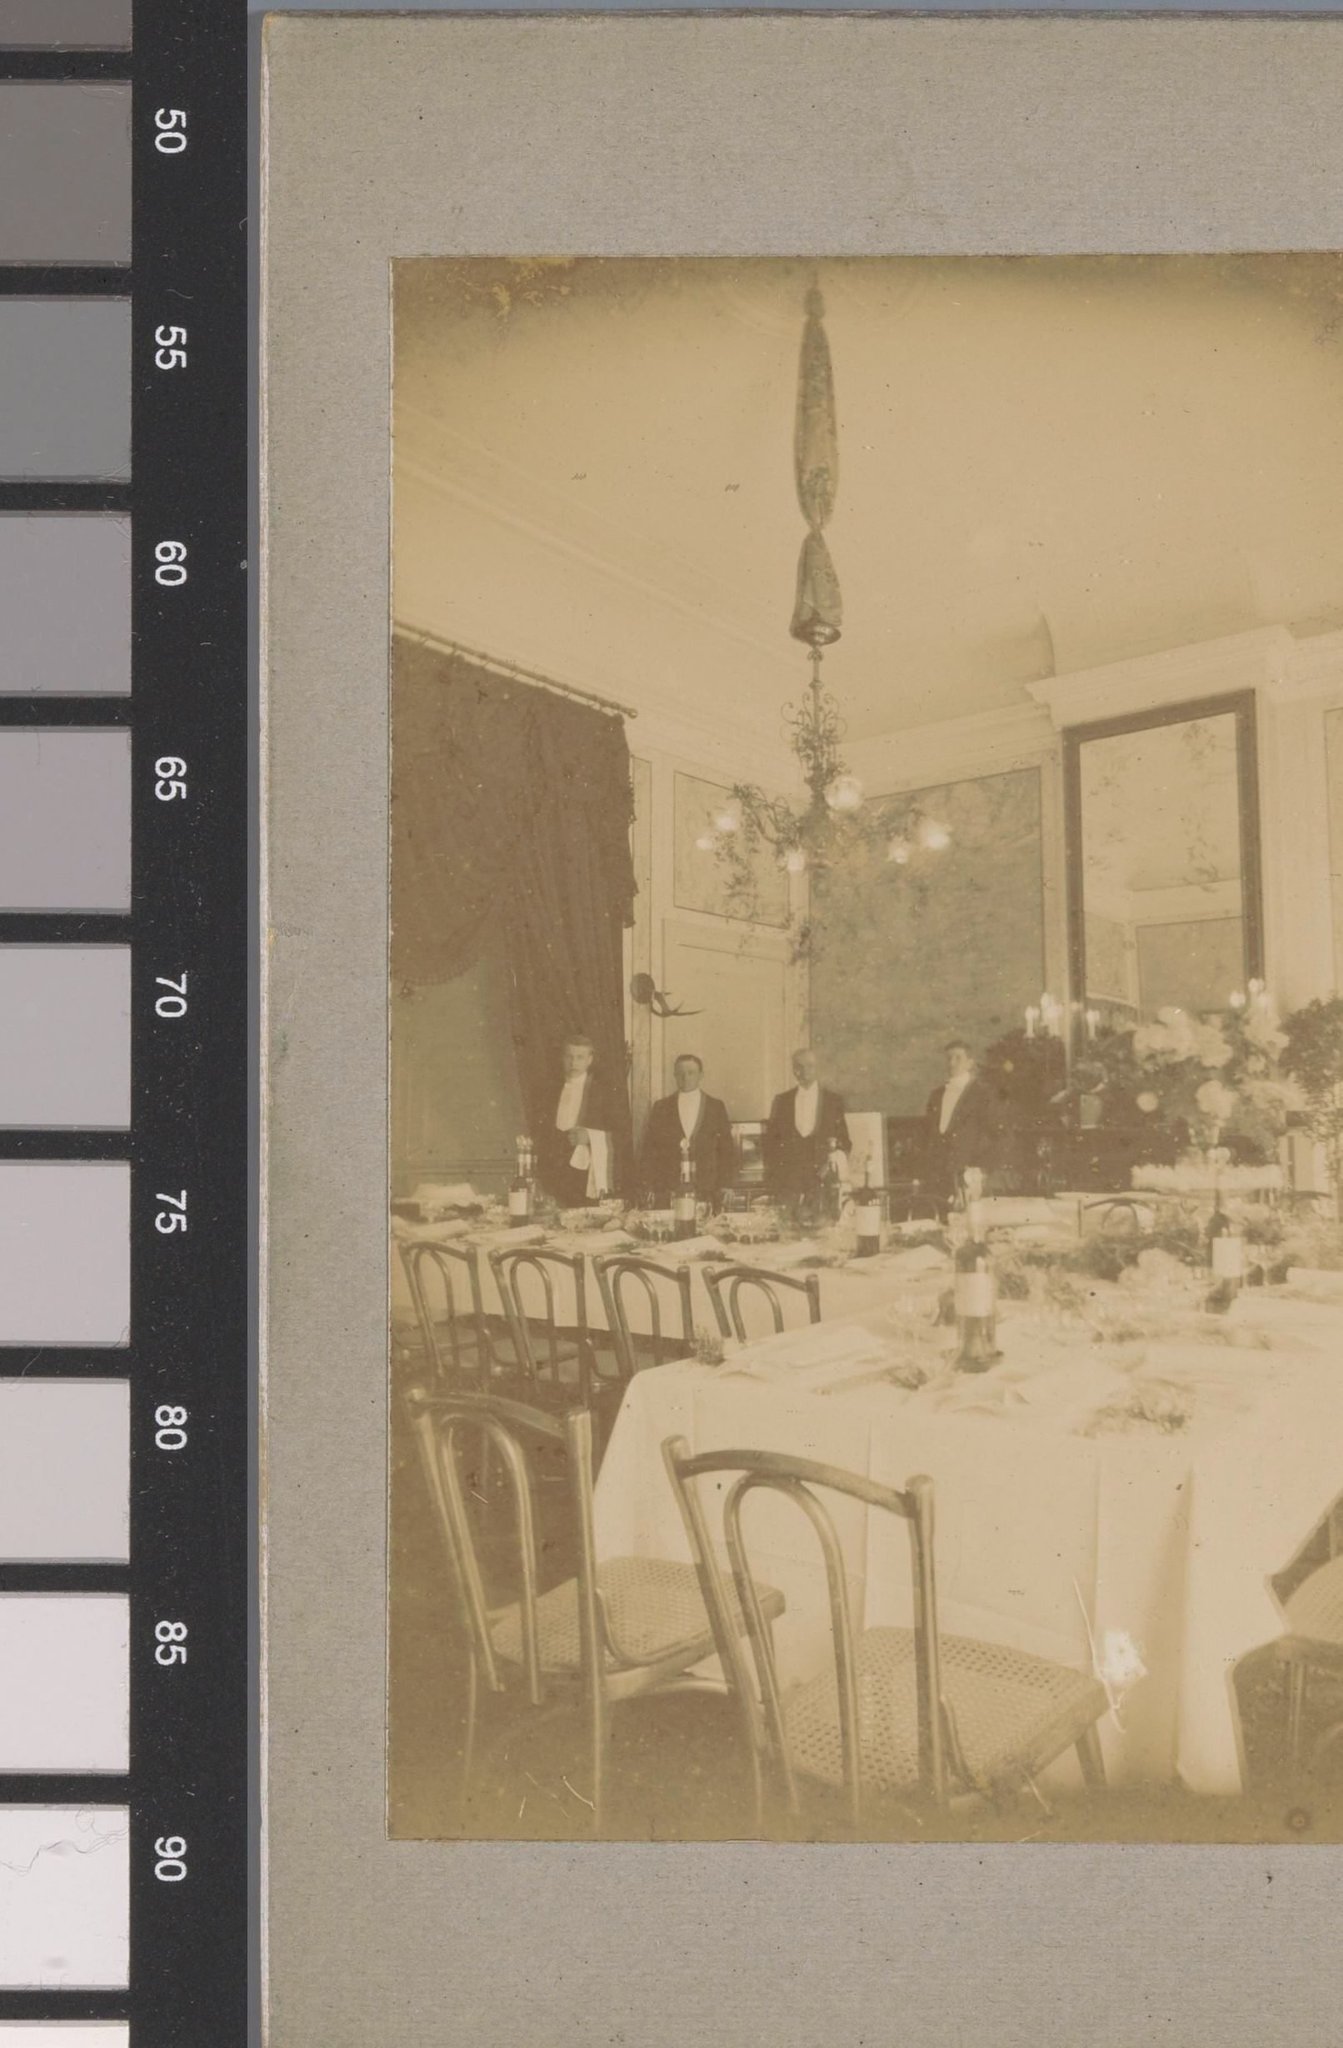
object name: carte de visite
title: Vier obers poserend achter een gedekte tafel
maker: Anonymous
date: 1900-1930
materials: cardboard, photographic support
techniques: gelatin silver print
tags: laid table: table-ware, table-decoration, etc., kitchen-personnel